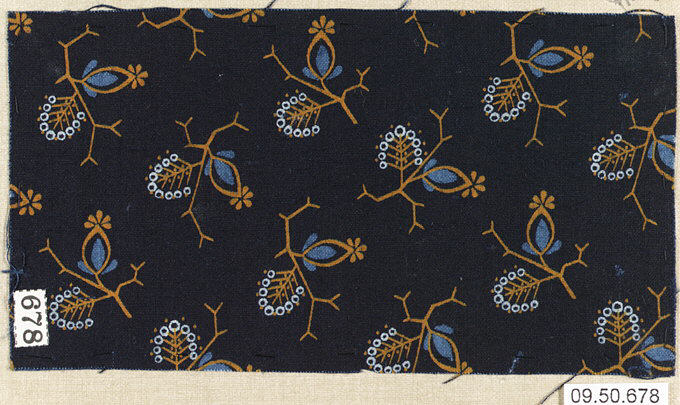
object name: piece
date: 1801-1900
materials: cotton